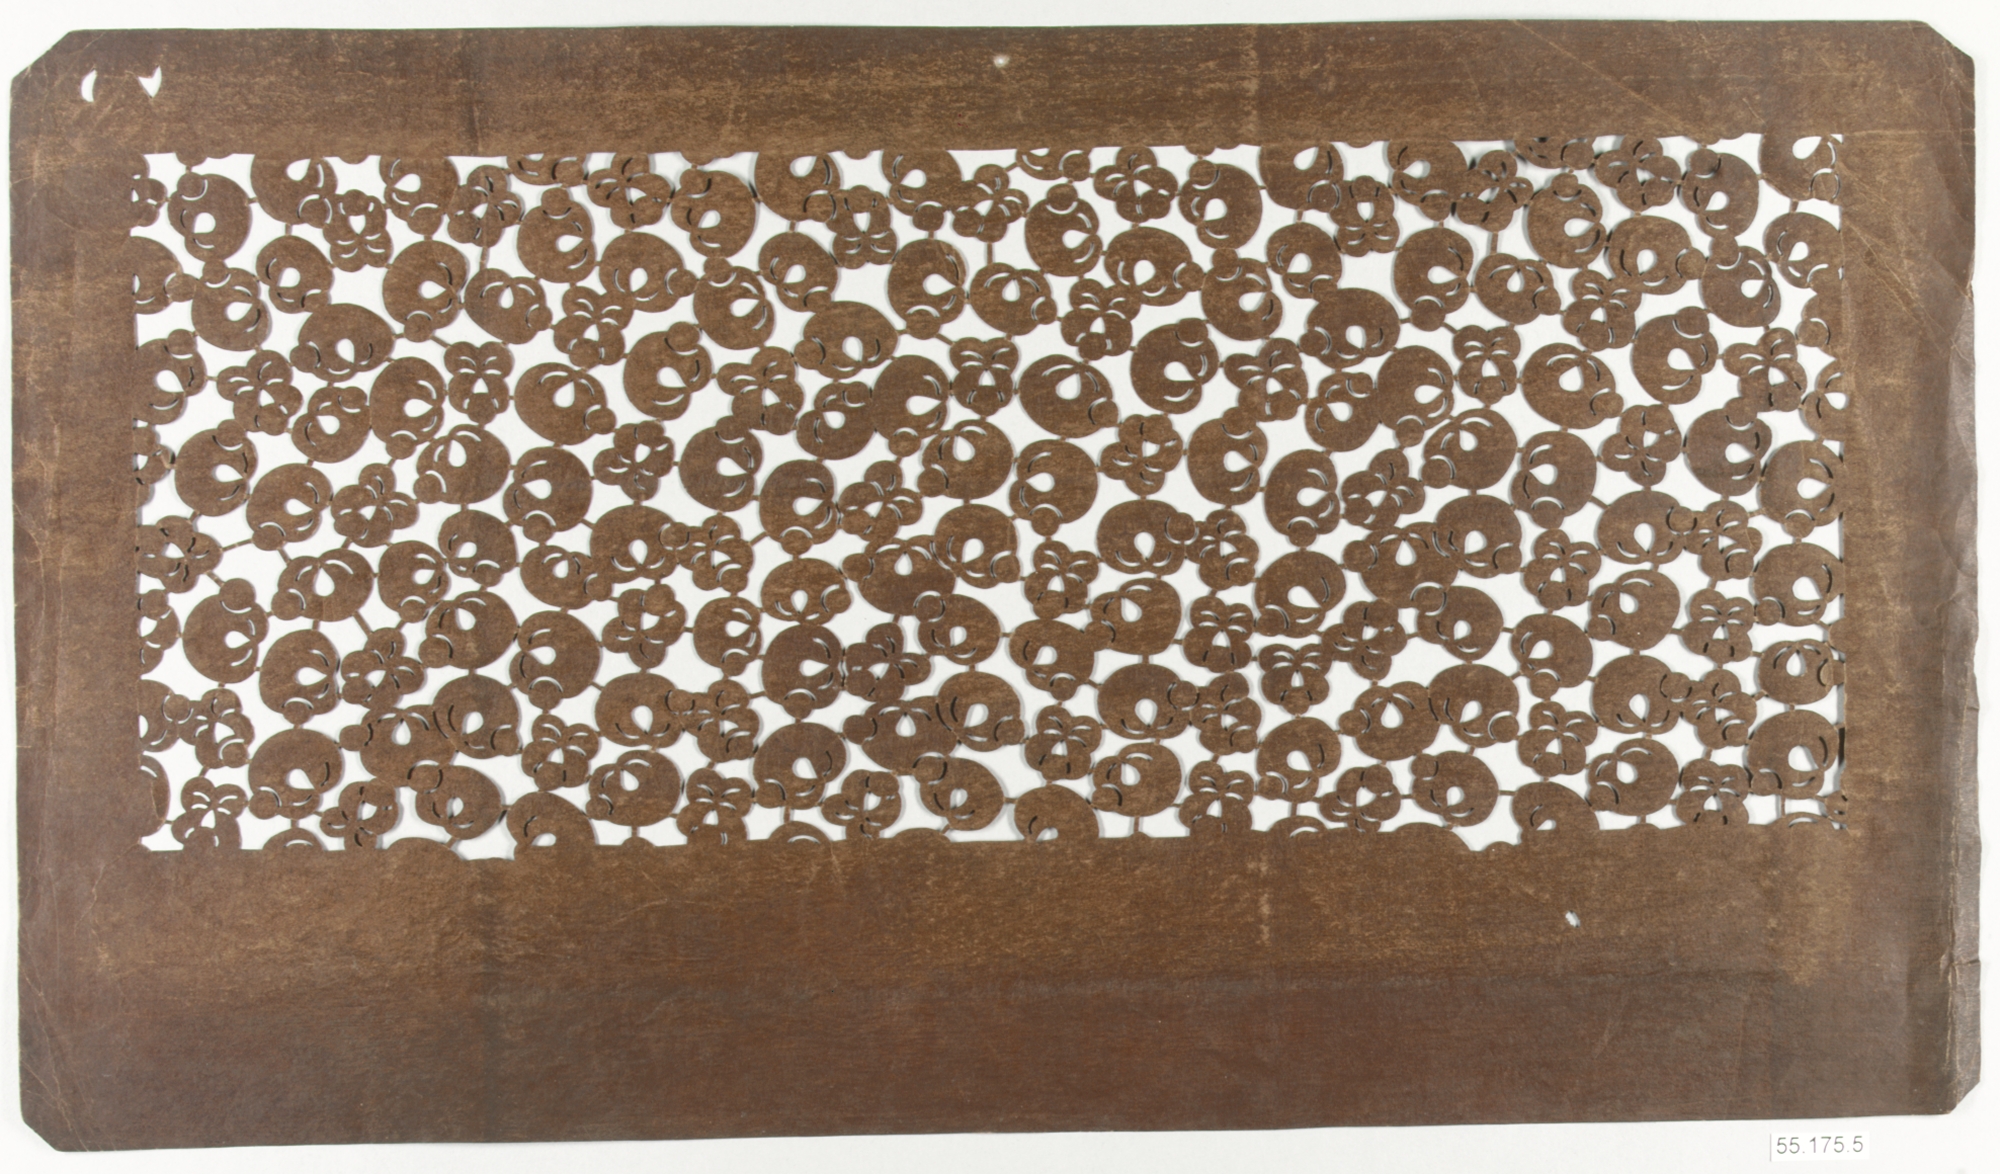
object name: stencil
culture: japanese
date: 1801-1900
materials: paper